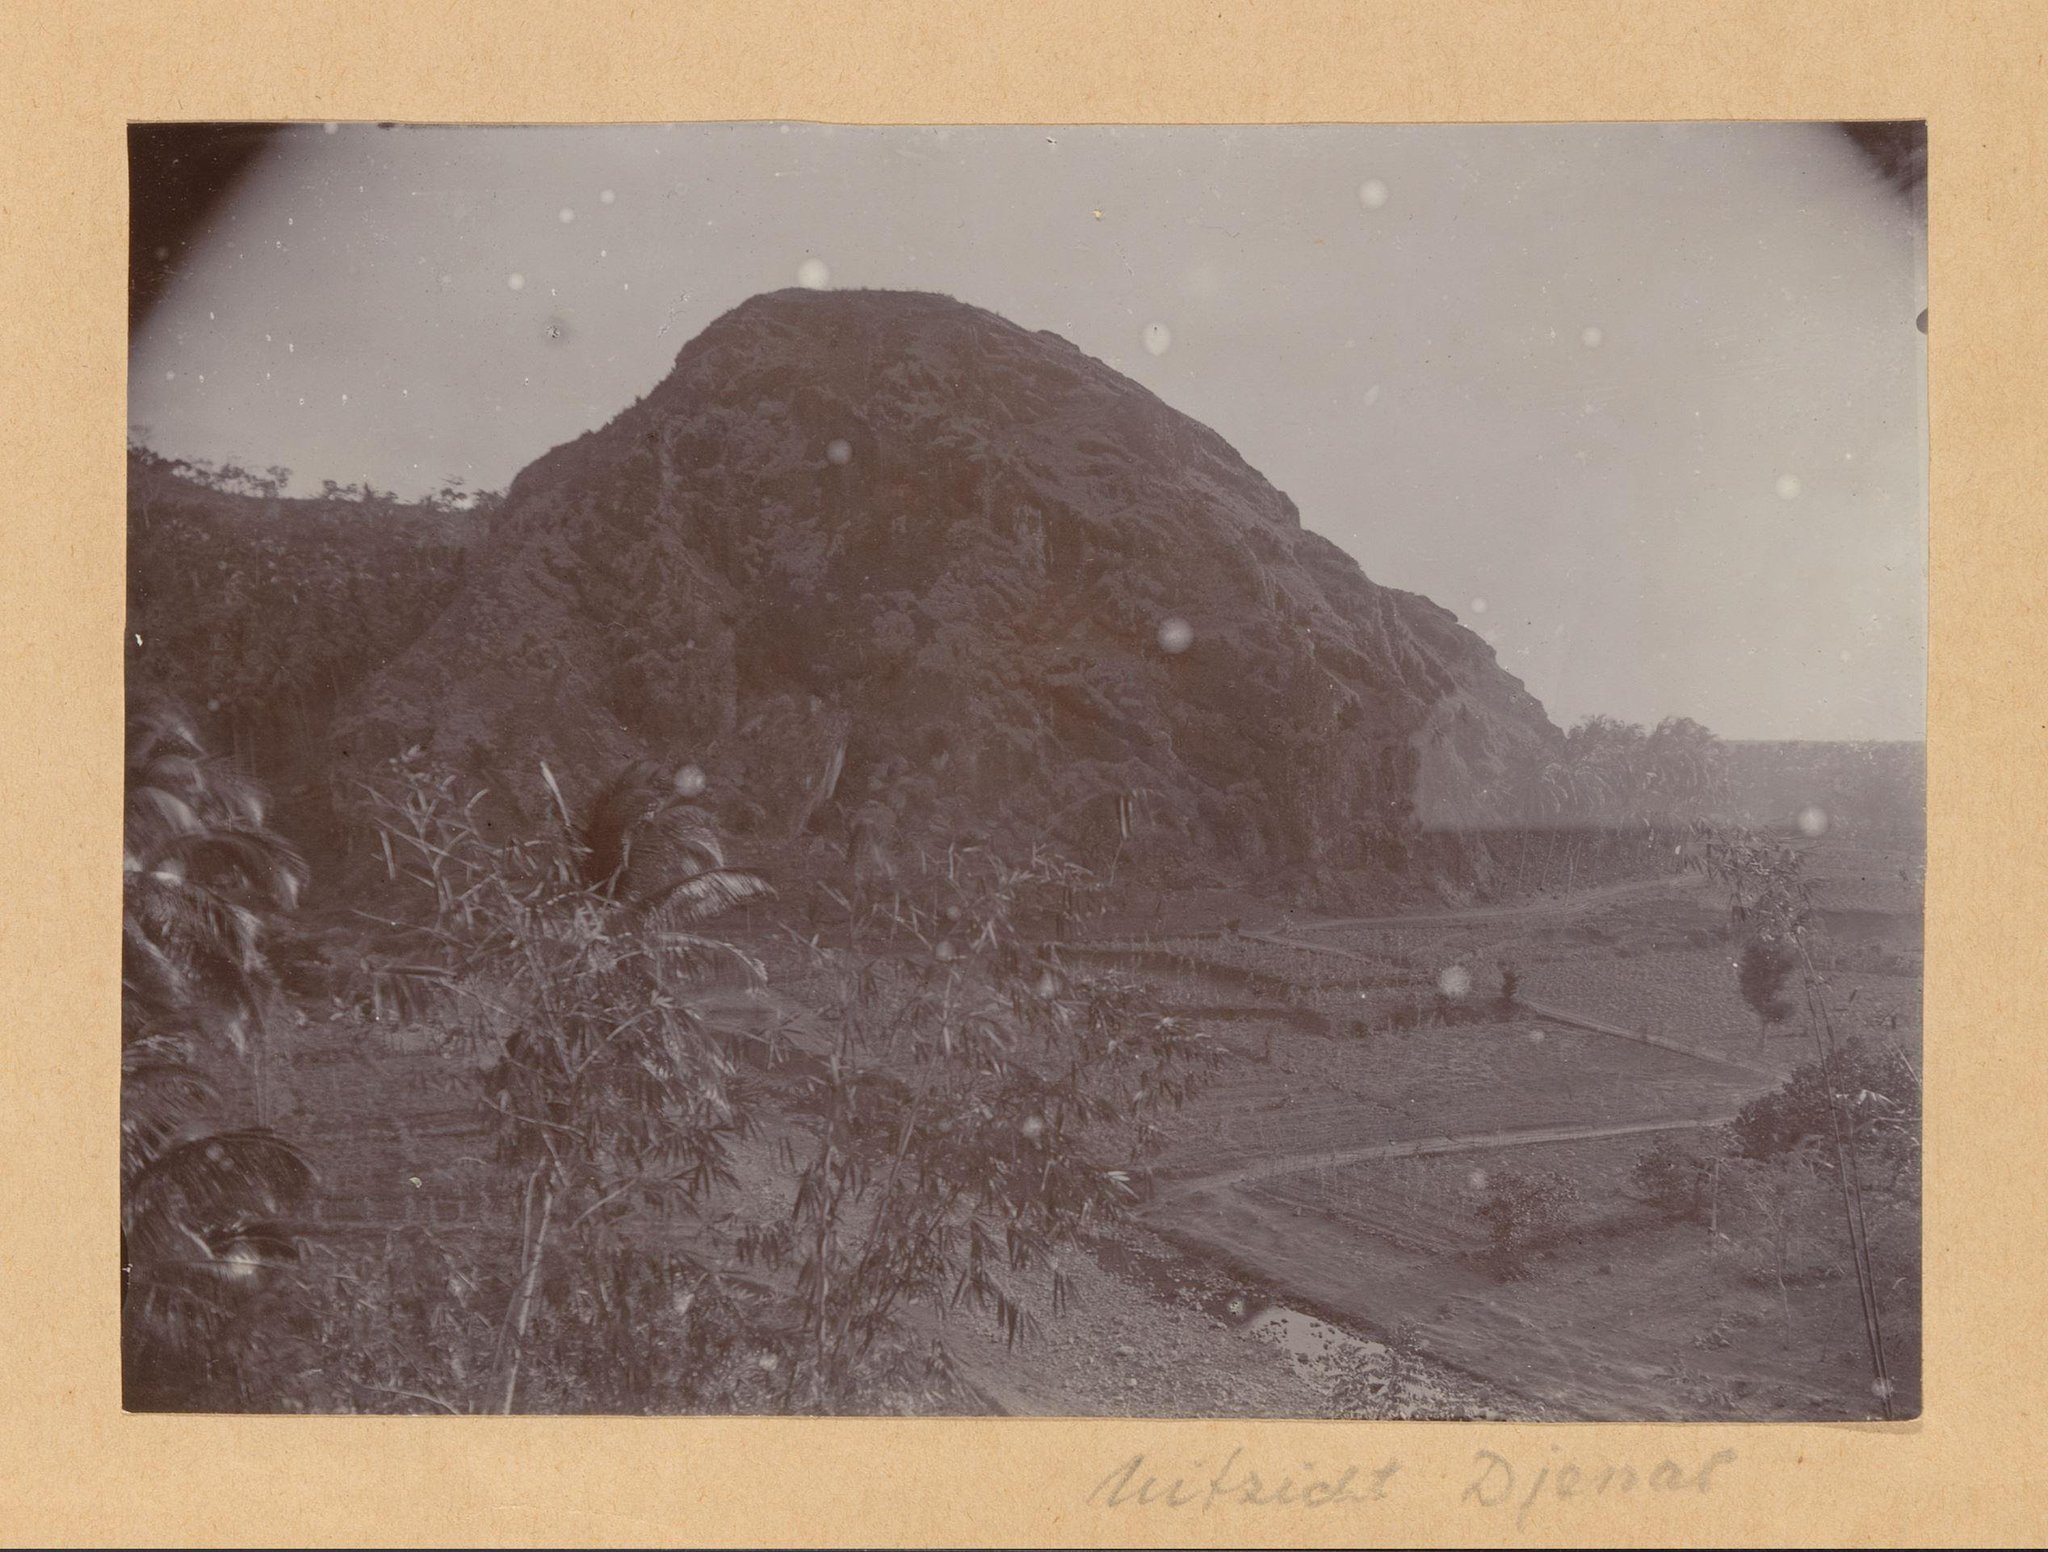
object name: photograph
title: Gezicht op een berg en velden bij Djenar op Java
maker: Anonymous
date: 1916-1917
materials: photographic support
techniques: gelatin silver print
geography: java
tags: field filled with a crop, mountains (in tropical and sub-tropical regions), dutch east indies, the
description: Onderdeel van Familiealbum met foto's van een familie in de voormalige kolonie Nederlands-Indië en van een suikerfabriek in Purworejo.